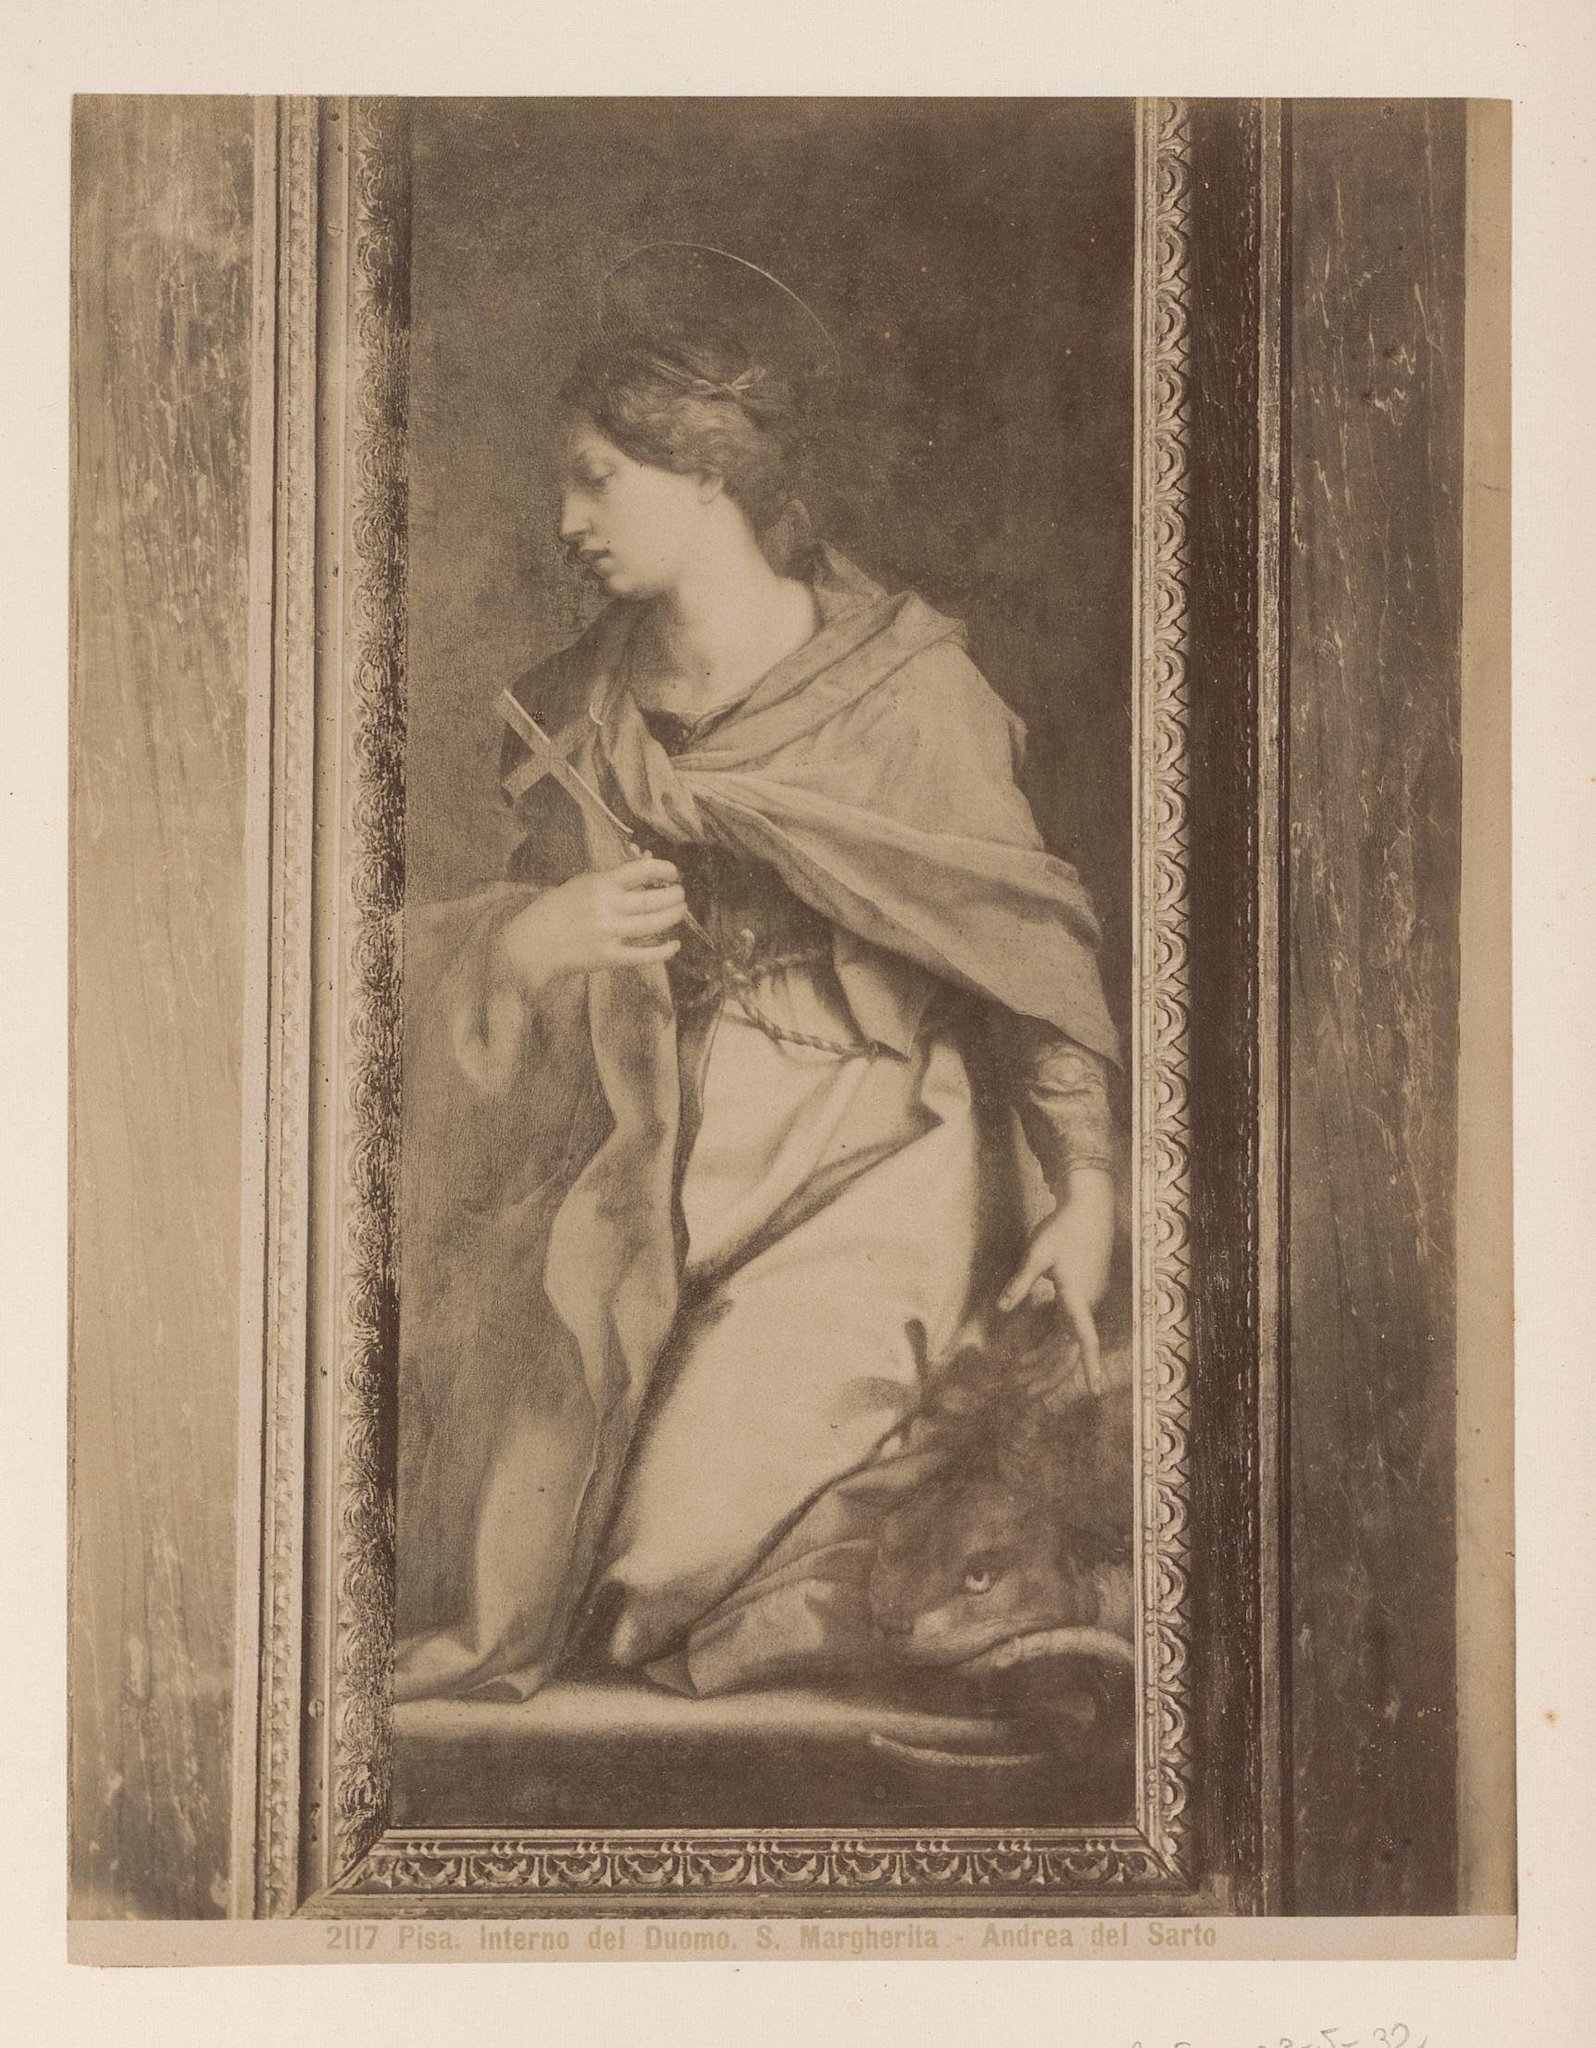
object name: reproduction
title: Fotoreproductie van een schilderij van Margaretha van Antiochië naar Andrea del Sarto in de Dom van Pisa, Italië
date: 1860-1881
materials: paper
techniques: albumen print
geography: pisa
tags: the virgin martyr margaret of antioch; possible attributes: cross, crown, dragon (under feet or on chain), (chaplet of) pearls, picture, painting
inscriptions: number: ‘2117’